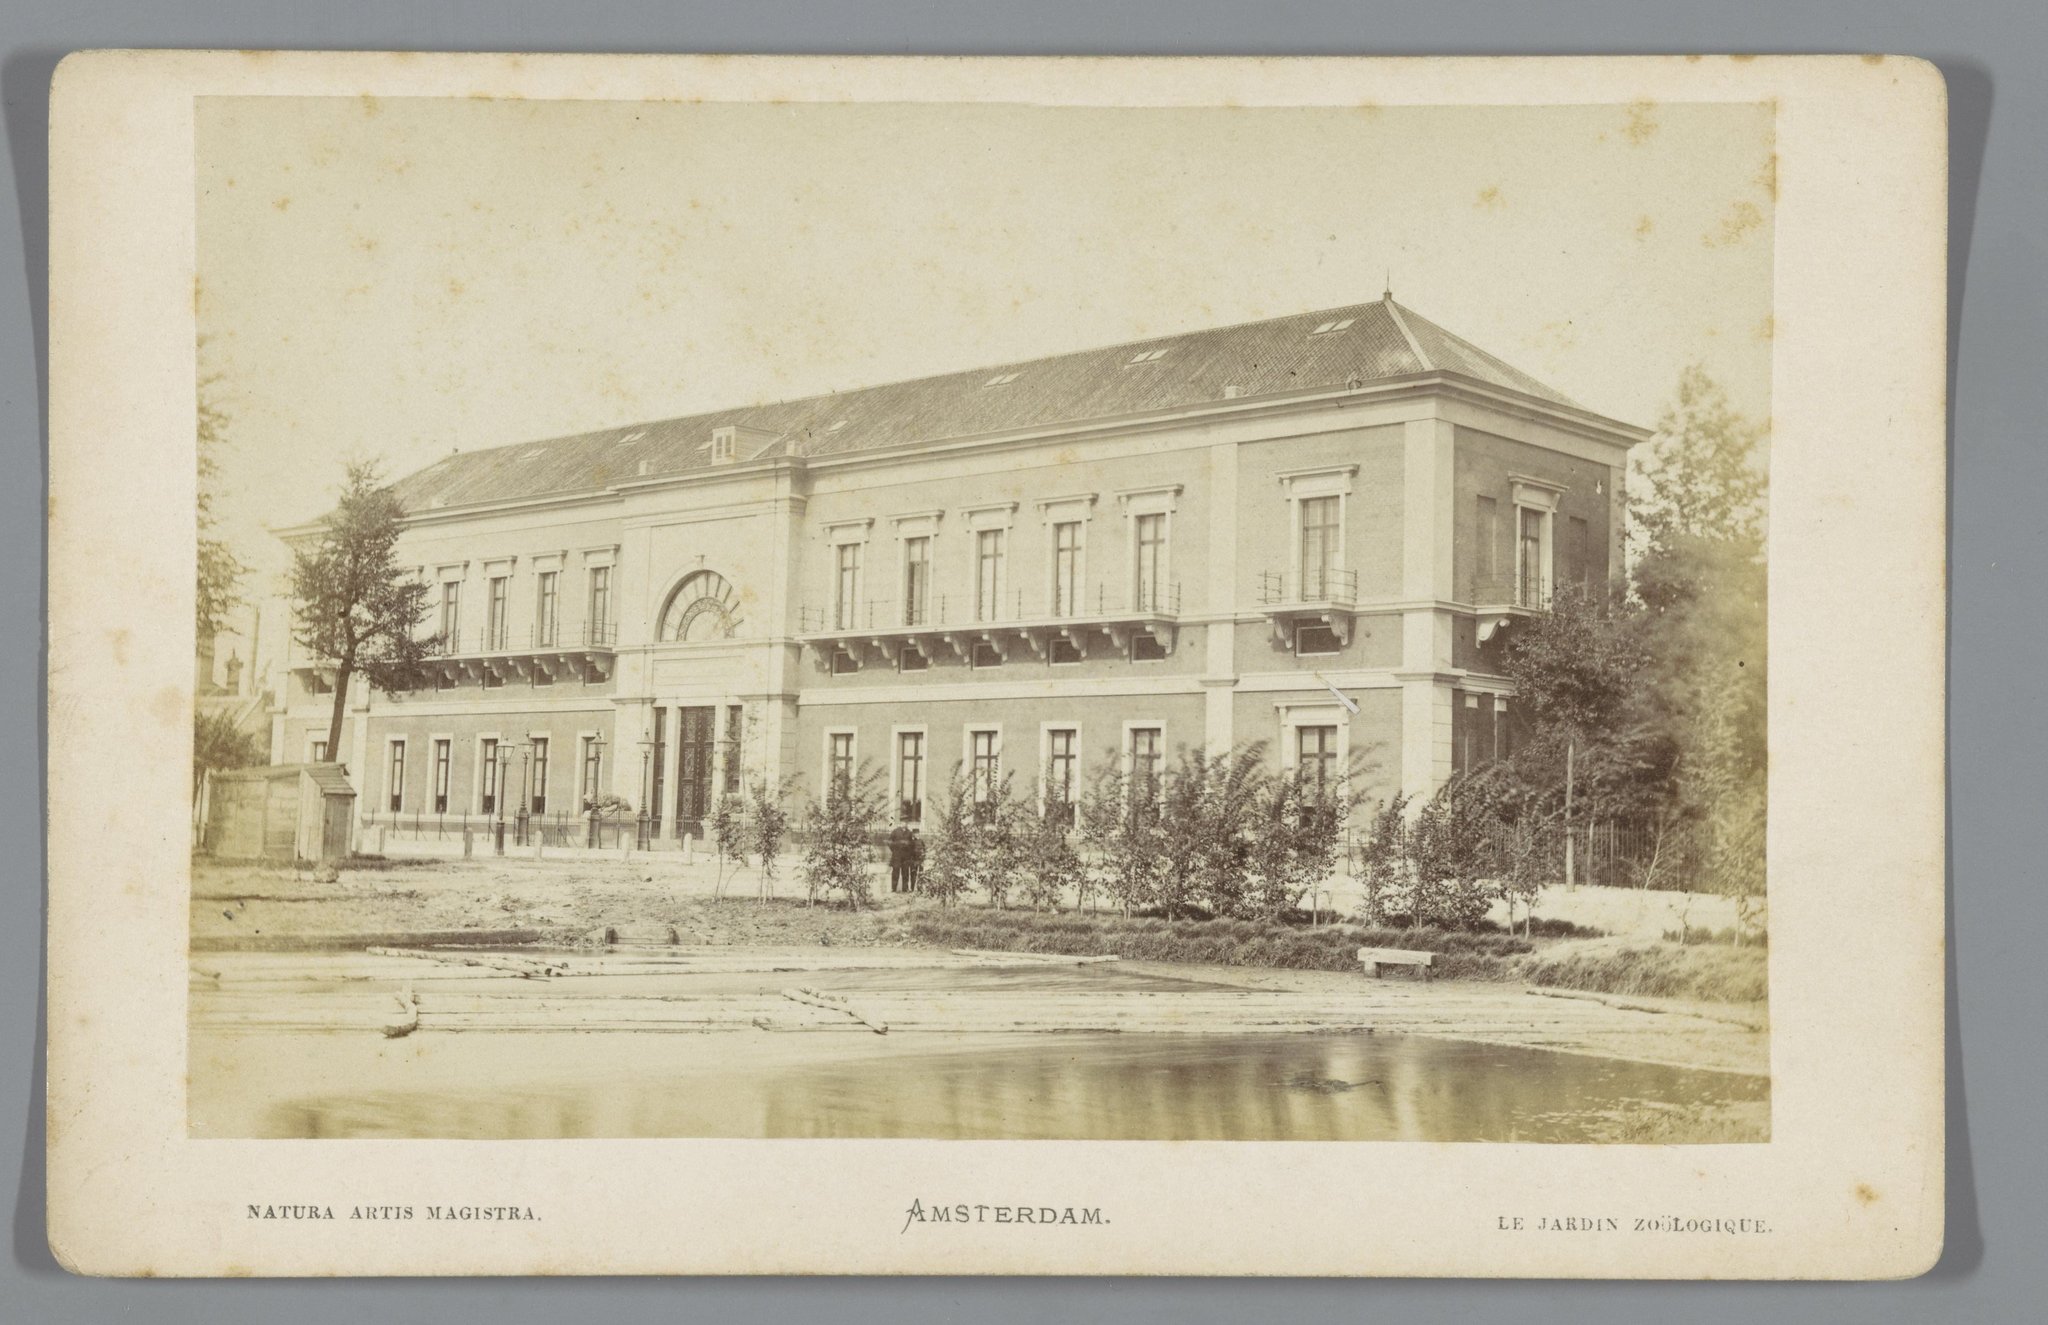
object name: cabinet photograph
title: Gezicht op het hoofdgebouw van Artis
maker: andries jager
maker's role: publisher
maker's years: 1825-1905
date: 1860-1890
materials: cardboard, photographic support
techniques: albumen print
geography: amsterdam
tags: permanent exhibition, museum, zoological garden, zoo, seen as place where non-domestic animals are kept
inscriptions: number: ‘18’